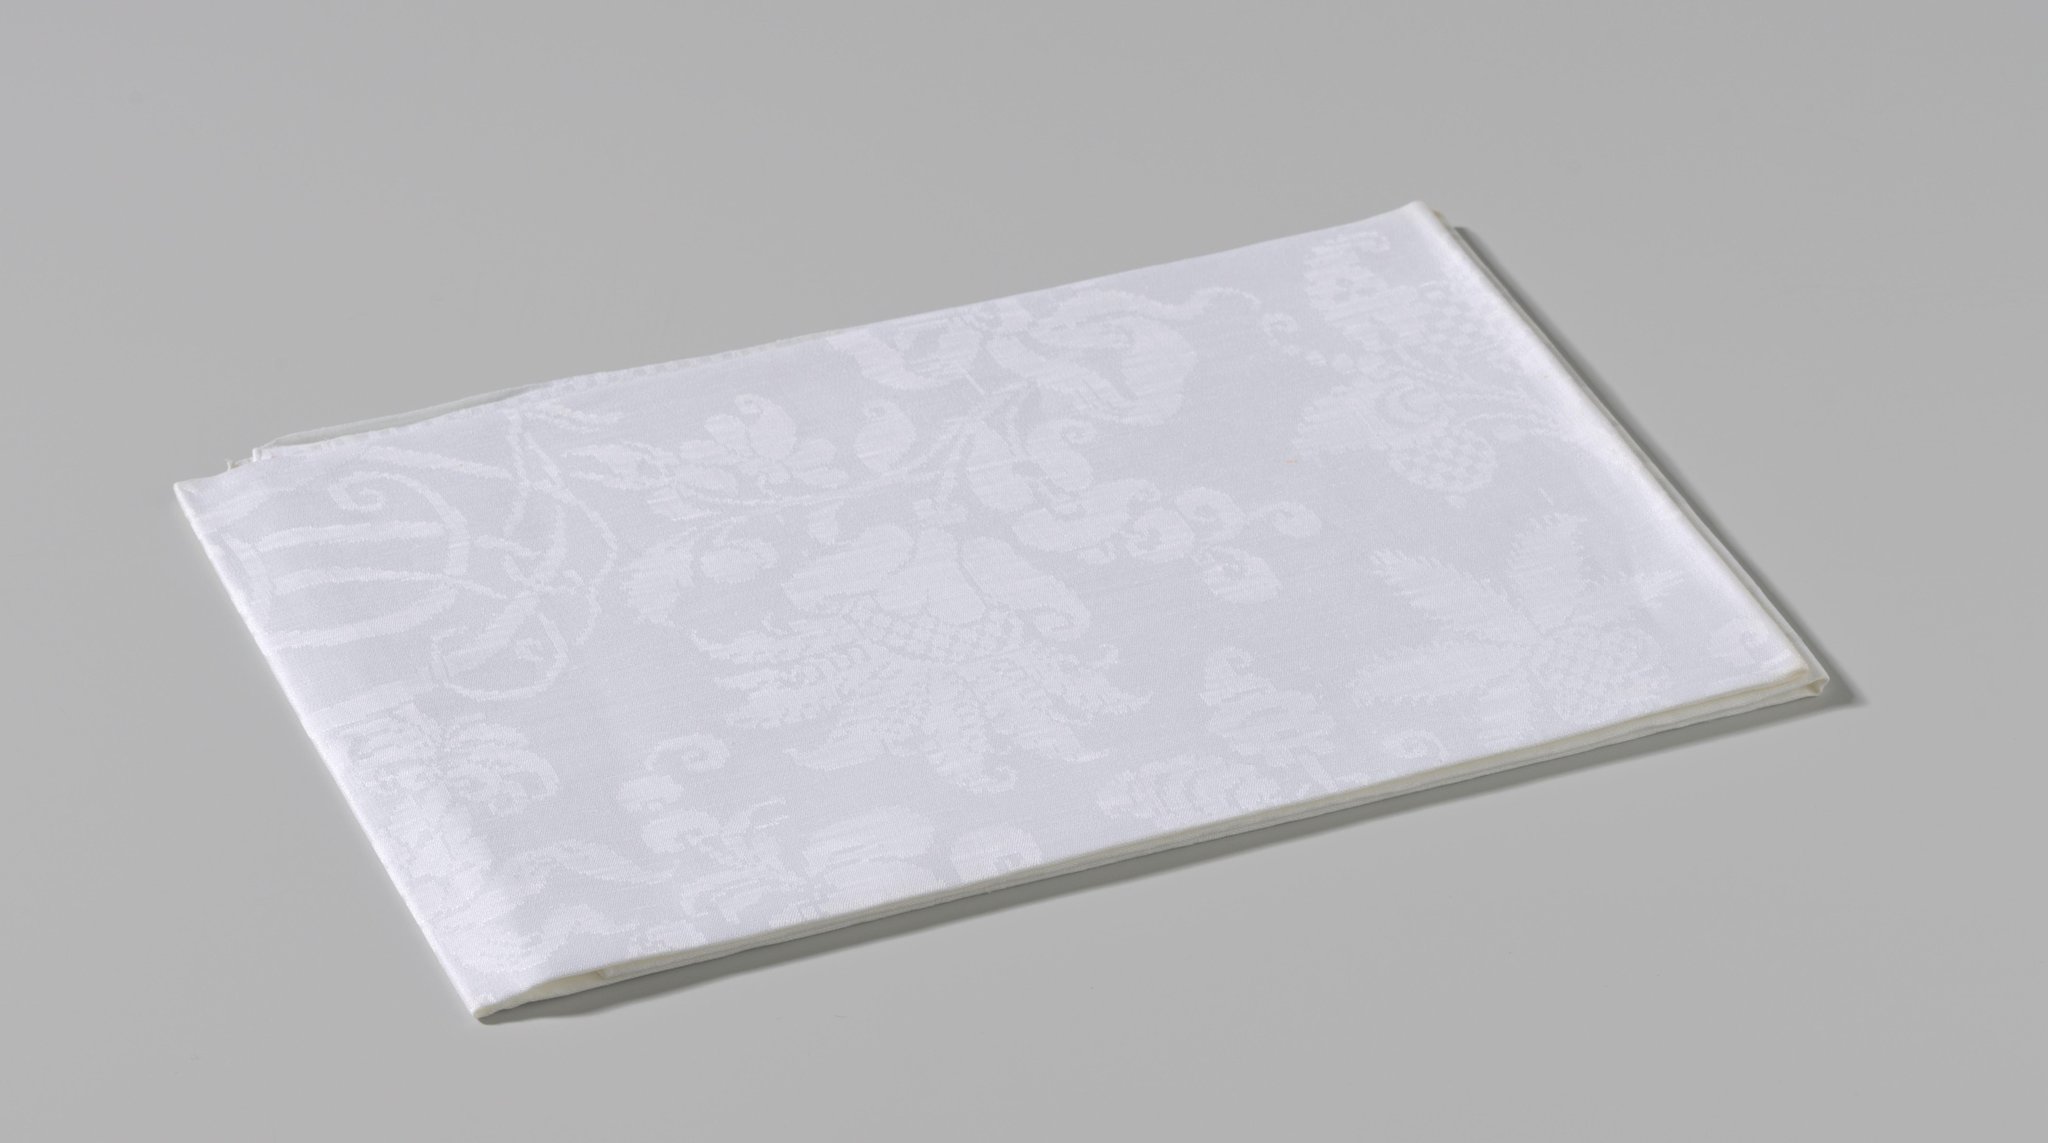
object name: napkin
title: Servet van linnendamast met een bloempatroon en wapen Rutgers en Block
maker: Anonymous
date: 1875-1900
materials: linen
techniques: damask, weave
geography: netherlands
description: Servet van linnendamast met bloemen, bladeren, vruchten aan takken, een ooievaar, een eekhoorn en een vlinder. In het midden het monogram DRMB, in de bovenhoeken het wapen van Rutgers en in de benedenhoeken het wapen van Block. Het servet hoort bij vijf servetten (BK-1973-194-A t/m BK-1973-194-F) die zijn gemaakt voor David Rutgers (1629-1707) en zijn vrouw Margaretha Block (1638-1702).